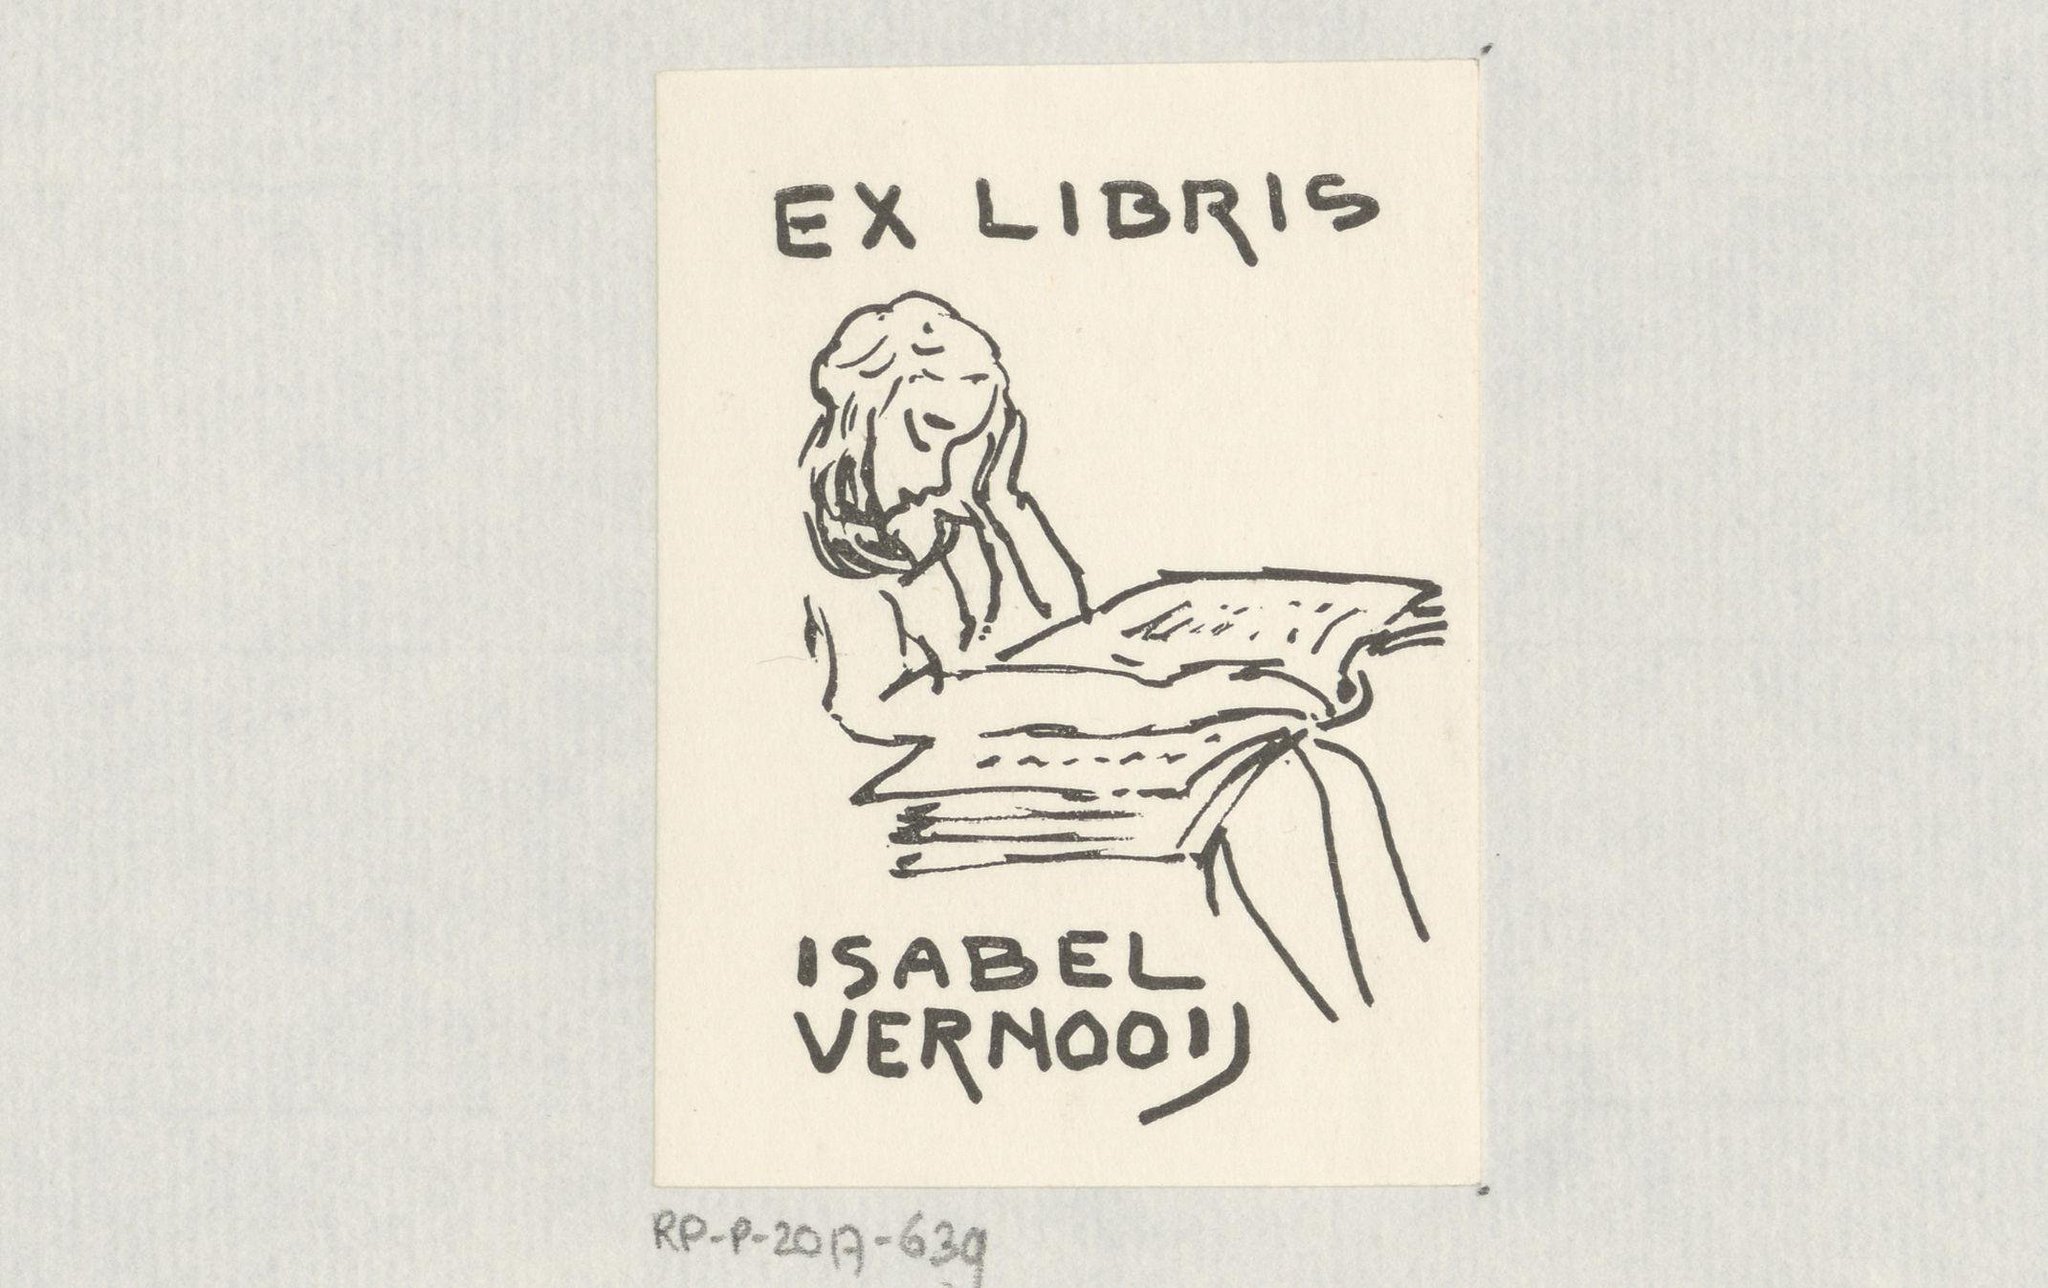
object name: bookplate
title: Ex libris van Isabel Vernooij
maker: c. bregman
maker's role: print maker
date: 1900-1999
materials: paper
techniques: printing block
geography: netherlands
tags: adolescent, young woman, maiden, reading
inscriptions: inscription: ‘C. Bregman’